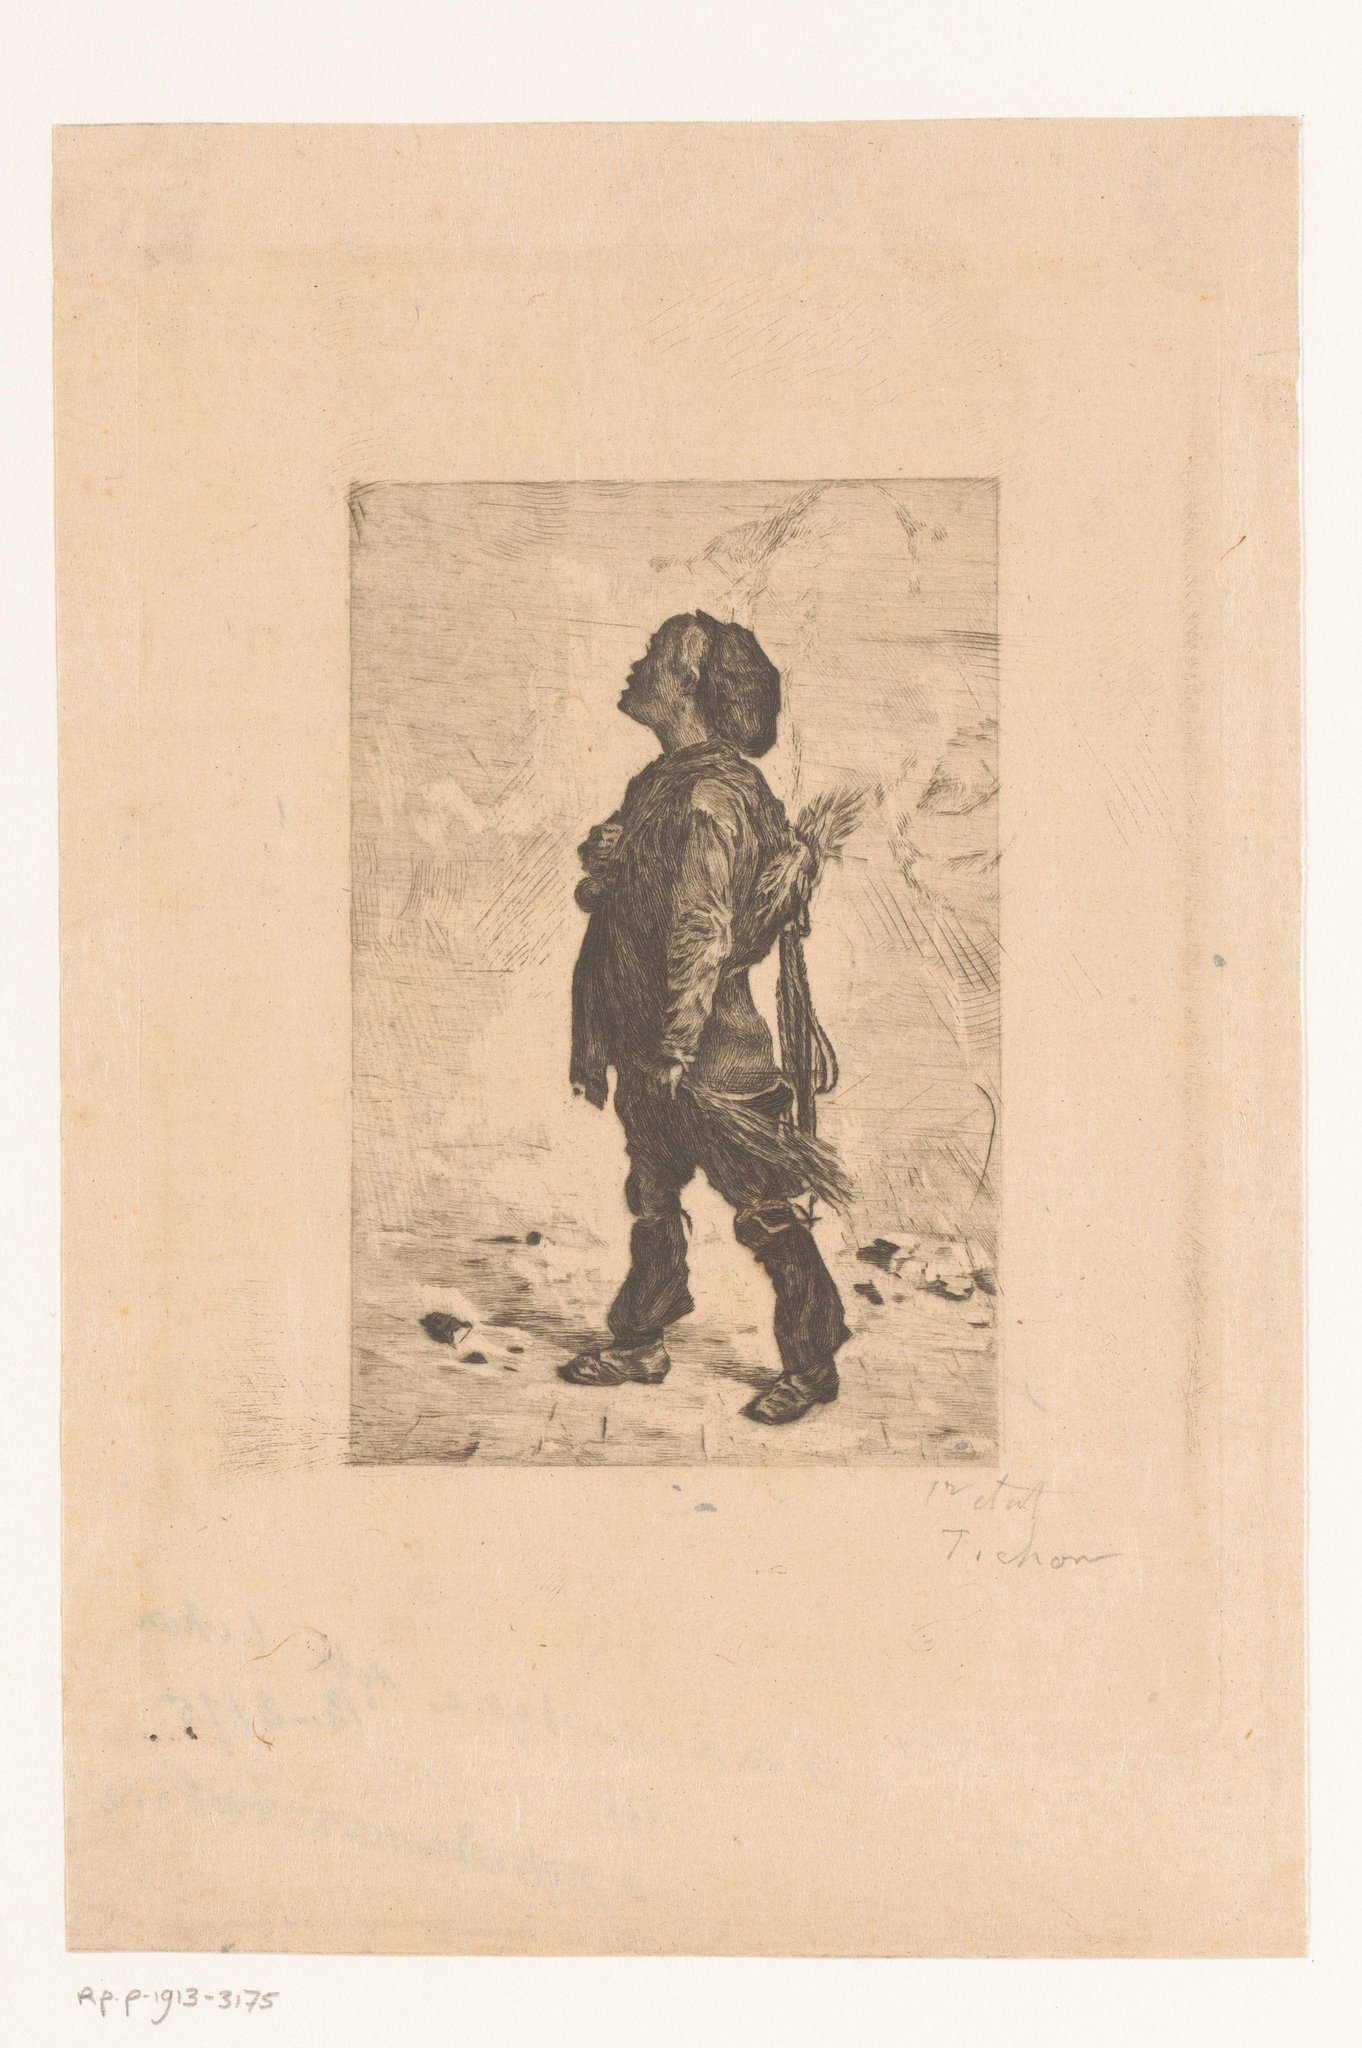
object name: print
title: Schoorsteenveger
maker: charles tichon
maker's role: draughtsman, painter, print maker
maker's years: 1865-1924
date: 1850-1913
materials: paper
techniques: etching, intaglio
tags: handicrafts ~ maintenance and repair (with name of trade or profession)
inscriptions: collector's mark: Lugt 2228, inscription: ‘1e etat’